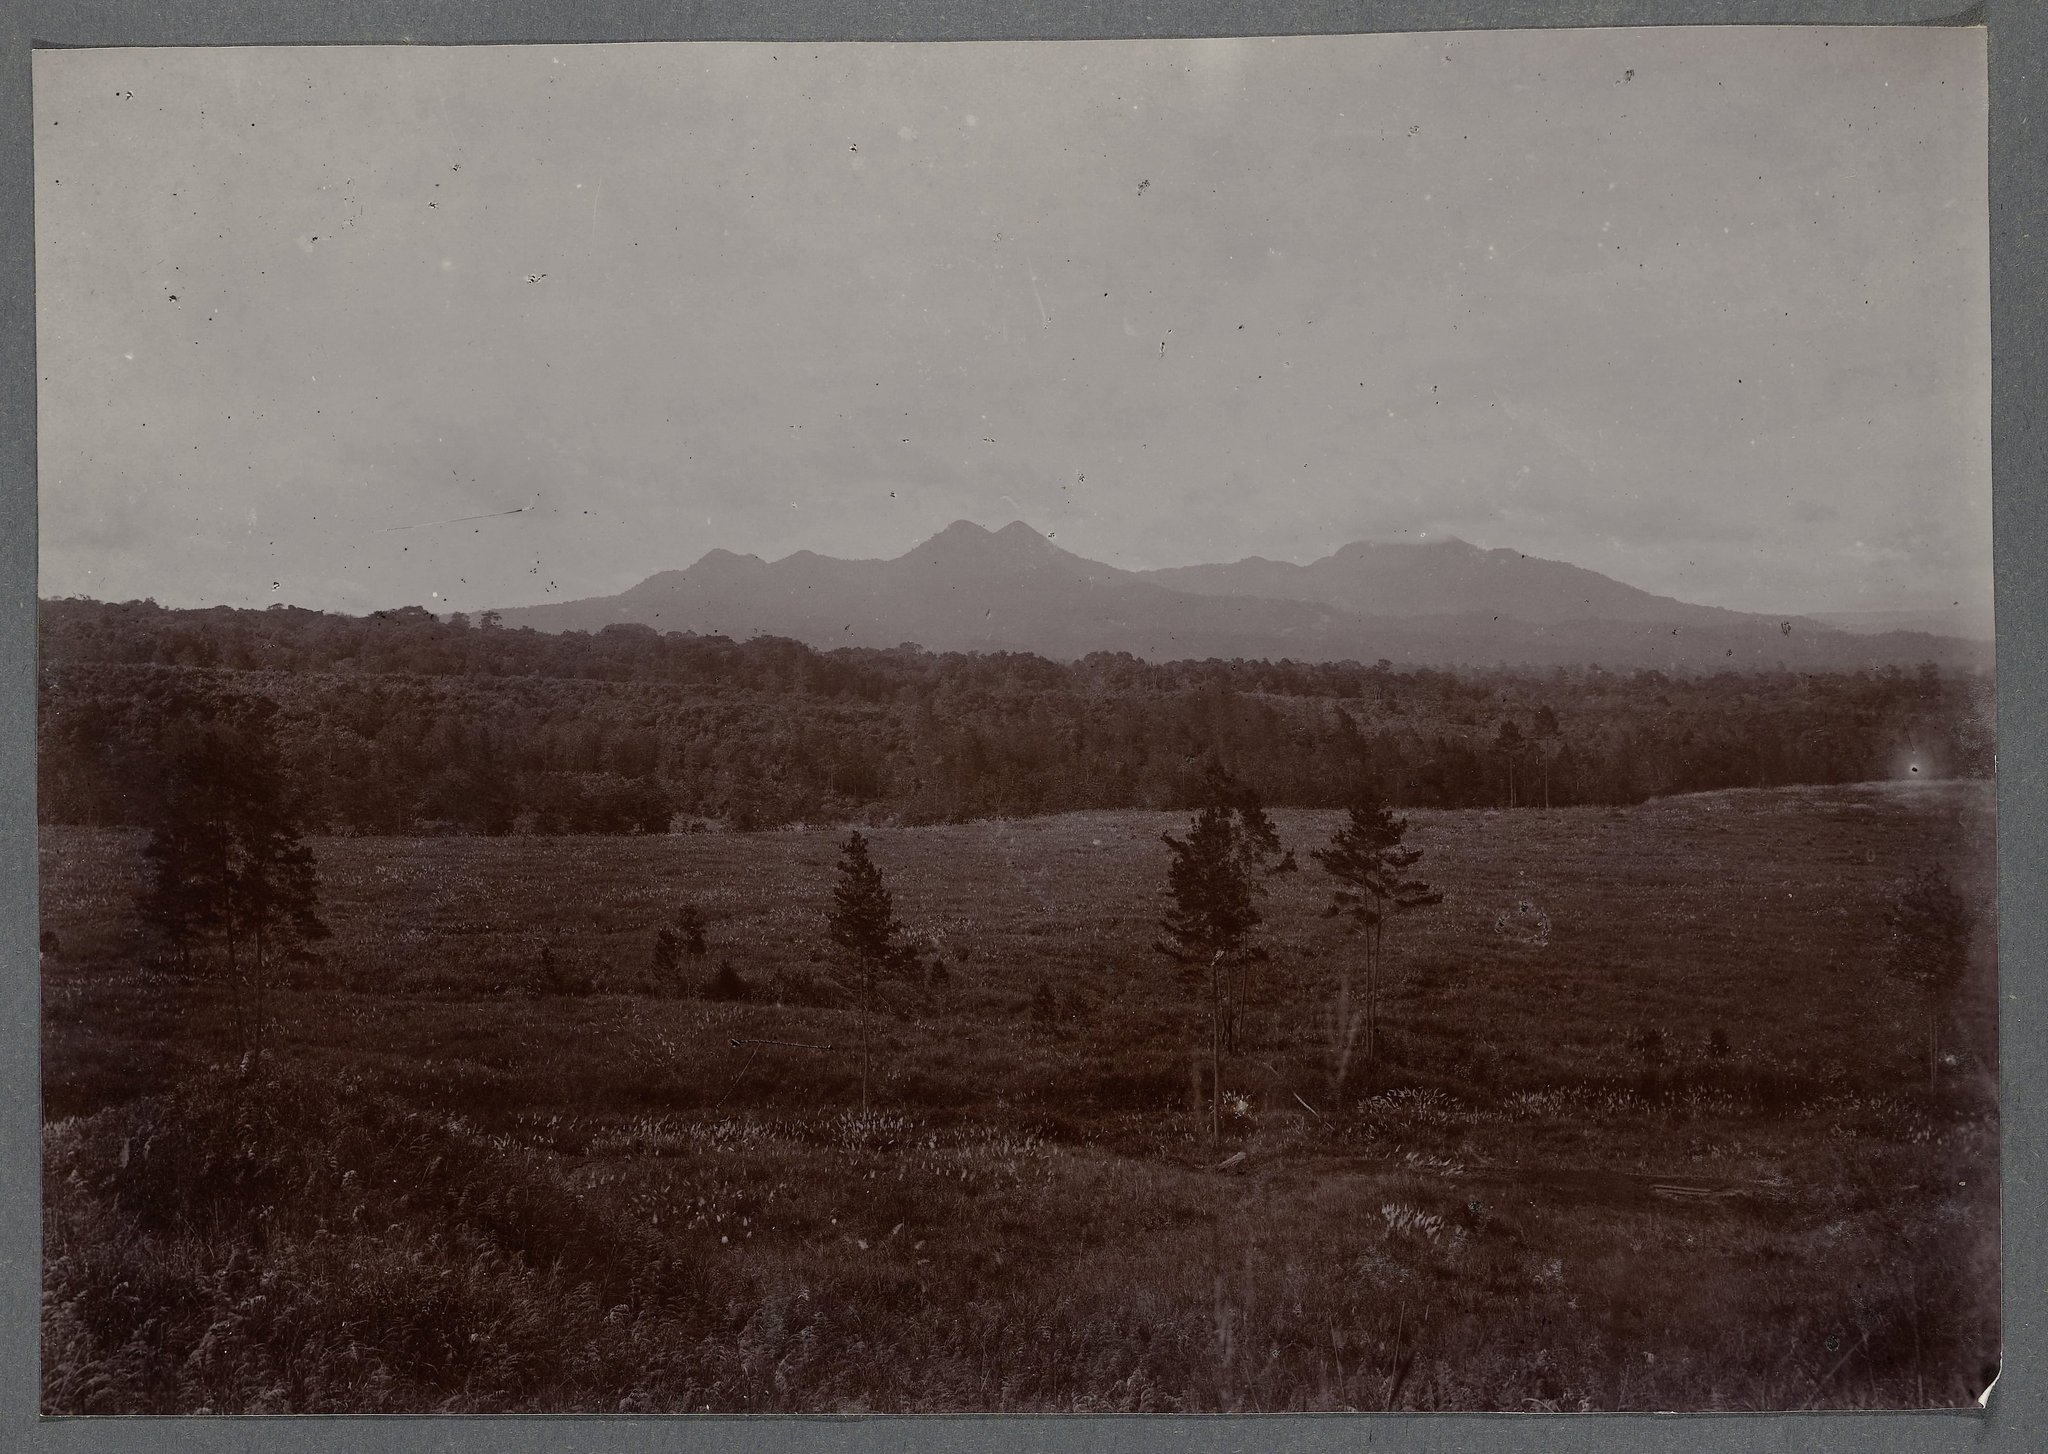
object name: photograph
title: Landschap met bergen in de verte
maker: Anonymous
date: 1903-1913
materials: photographic support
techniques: gelatin silver print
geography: north sumatra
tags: albertus dominicus laman trip, building activities, traffic by road or path with motor-vehicle, landscapes in tropical and sub-tropical regions, road, path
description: Na de expedities naar de Gajo- en Alaslanden o.l.v. Van Daalen (eerste tocht in 1901), werd hij in 1903 belast met voorbereiding van permanente vestiging van Nederlands gezag. Aanleg van een weg van de Noordkust naar het binnenland was hierbij van groot belang. Deze zgn. Gajoweg werd aangelegd tussen 1903 en 1914, van Bireuen aan de kust naar Takinguen aan het bergmeer Danau Lauttawar, totale lengte 104 km.